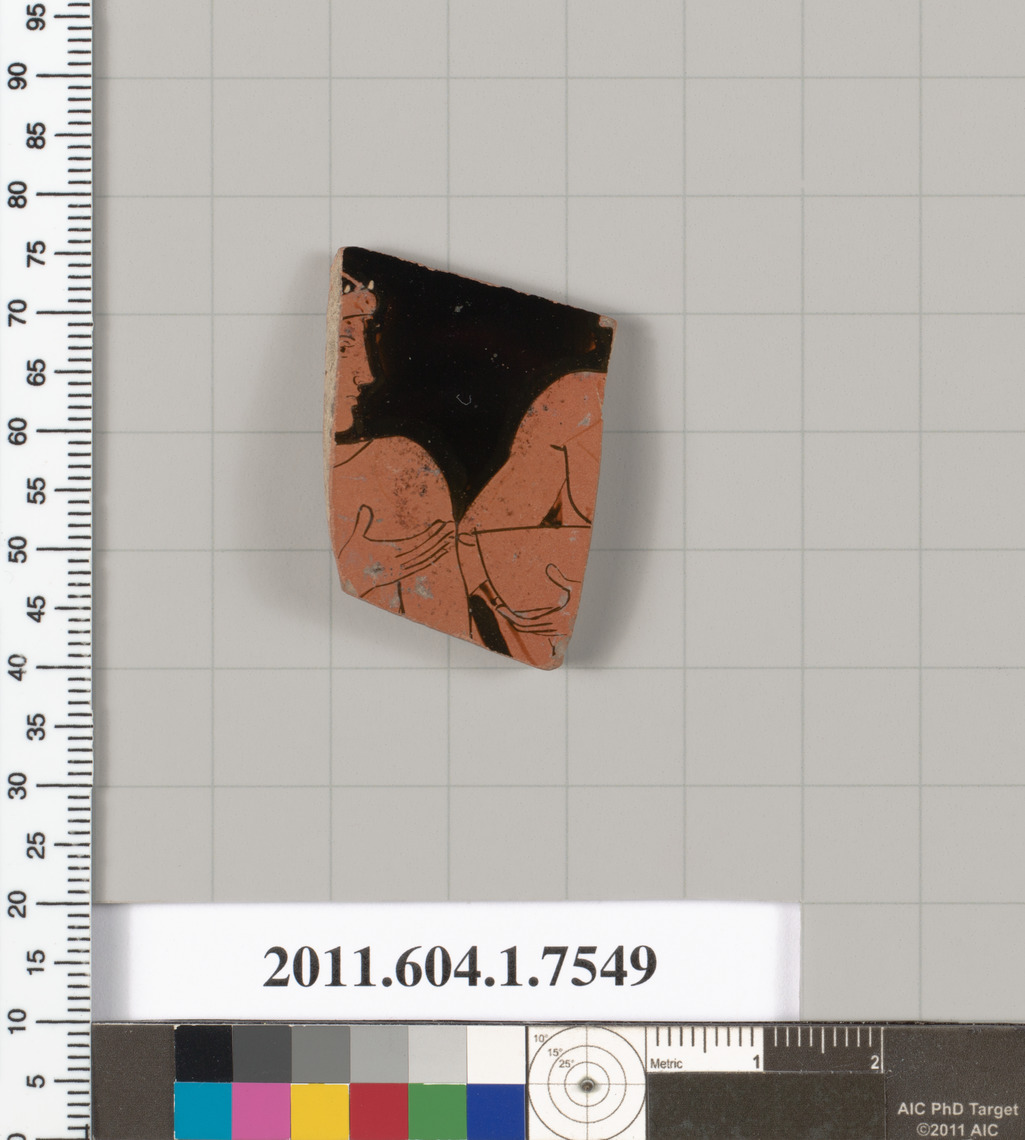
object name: kylix fragment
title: Terracotta fragment of a kylix (drinking cup)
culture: greek, attic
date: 460-450 BCE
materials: terracotta